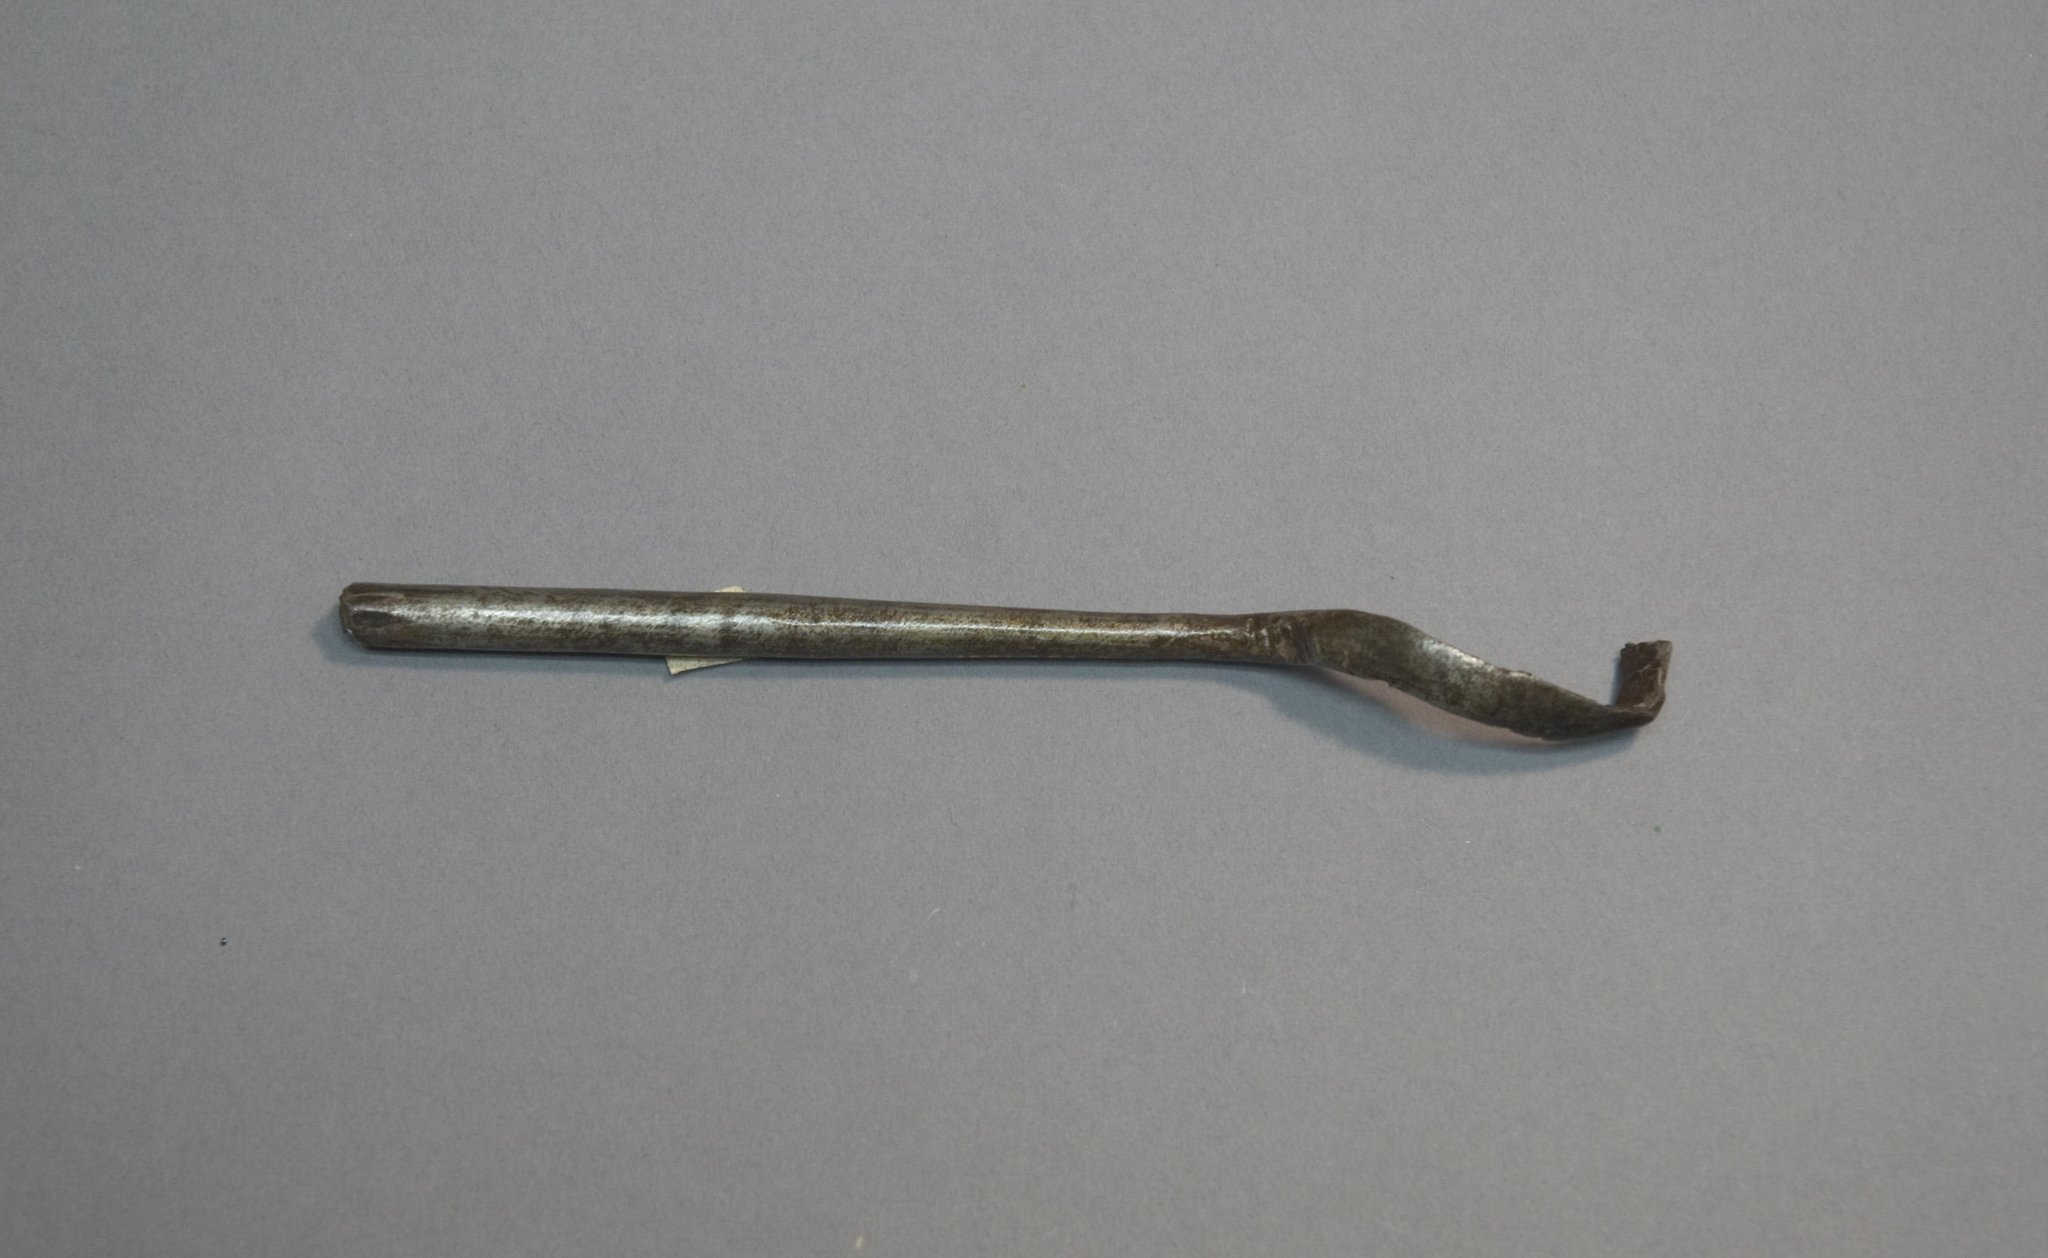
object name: jade carving tool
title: Gouge for carving jade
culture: chinese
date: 1901-2000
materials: steel